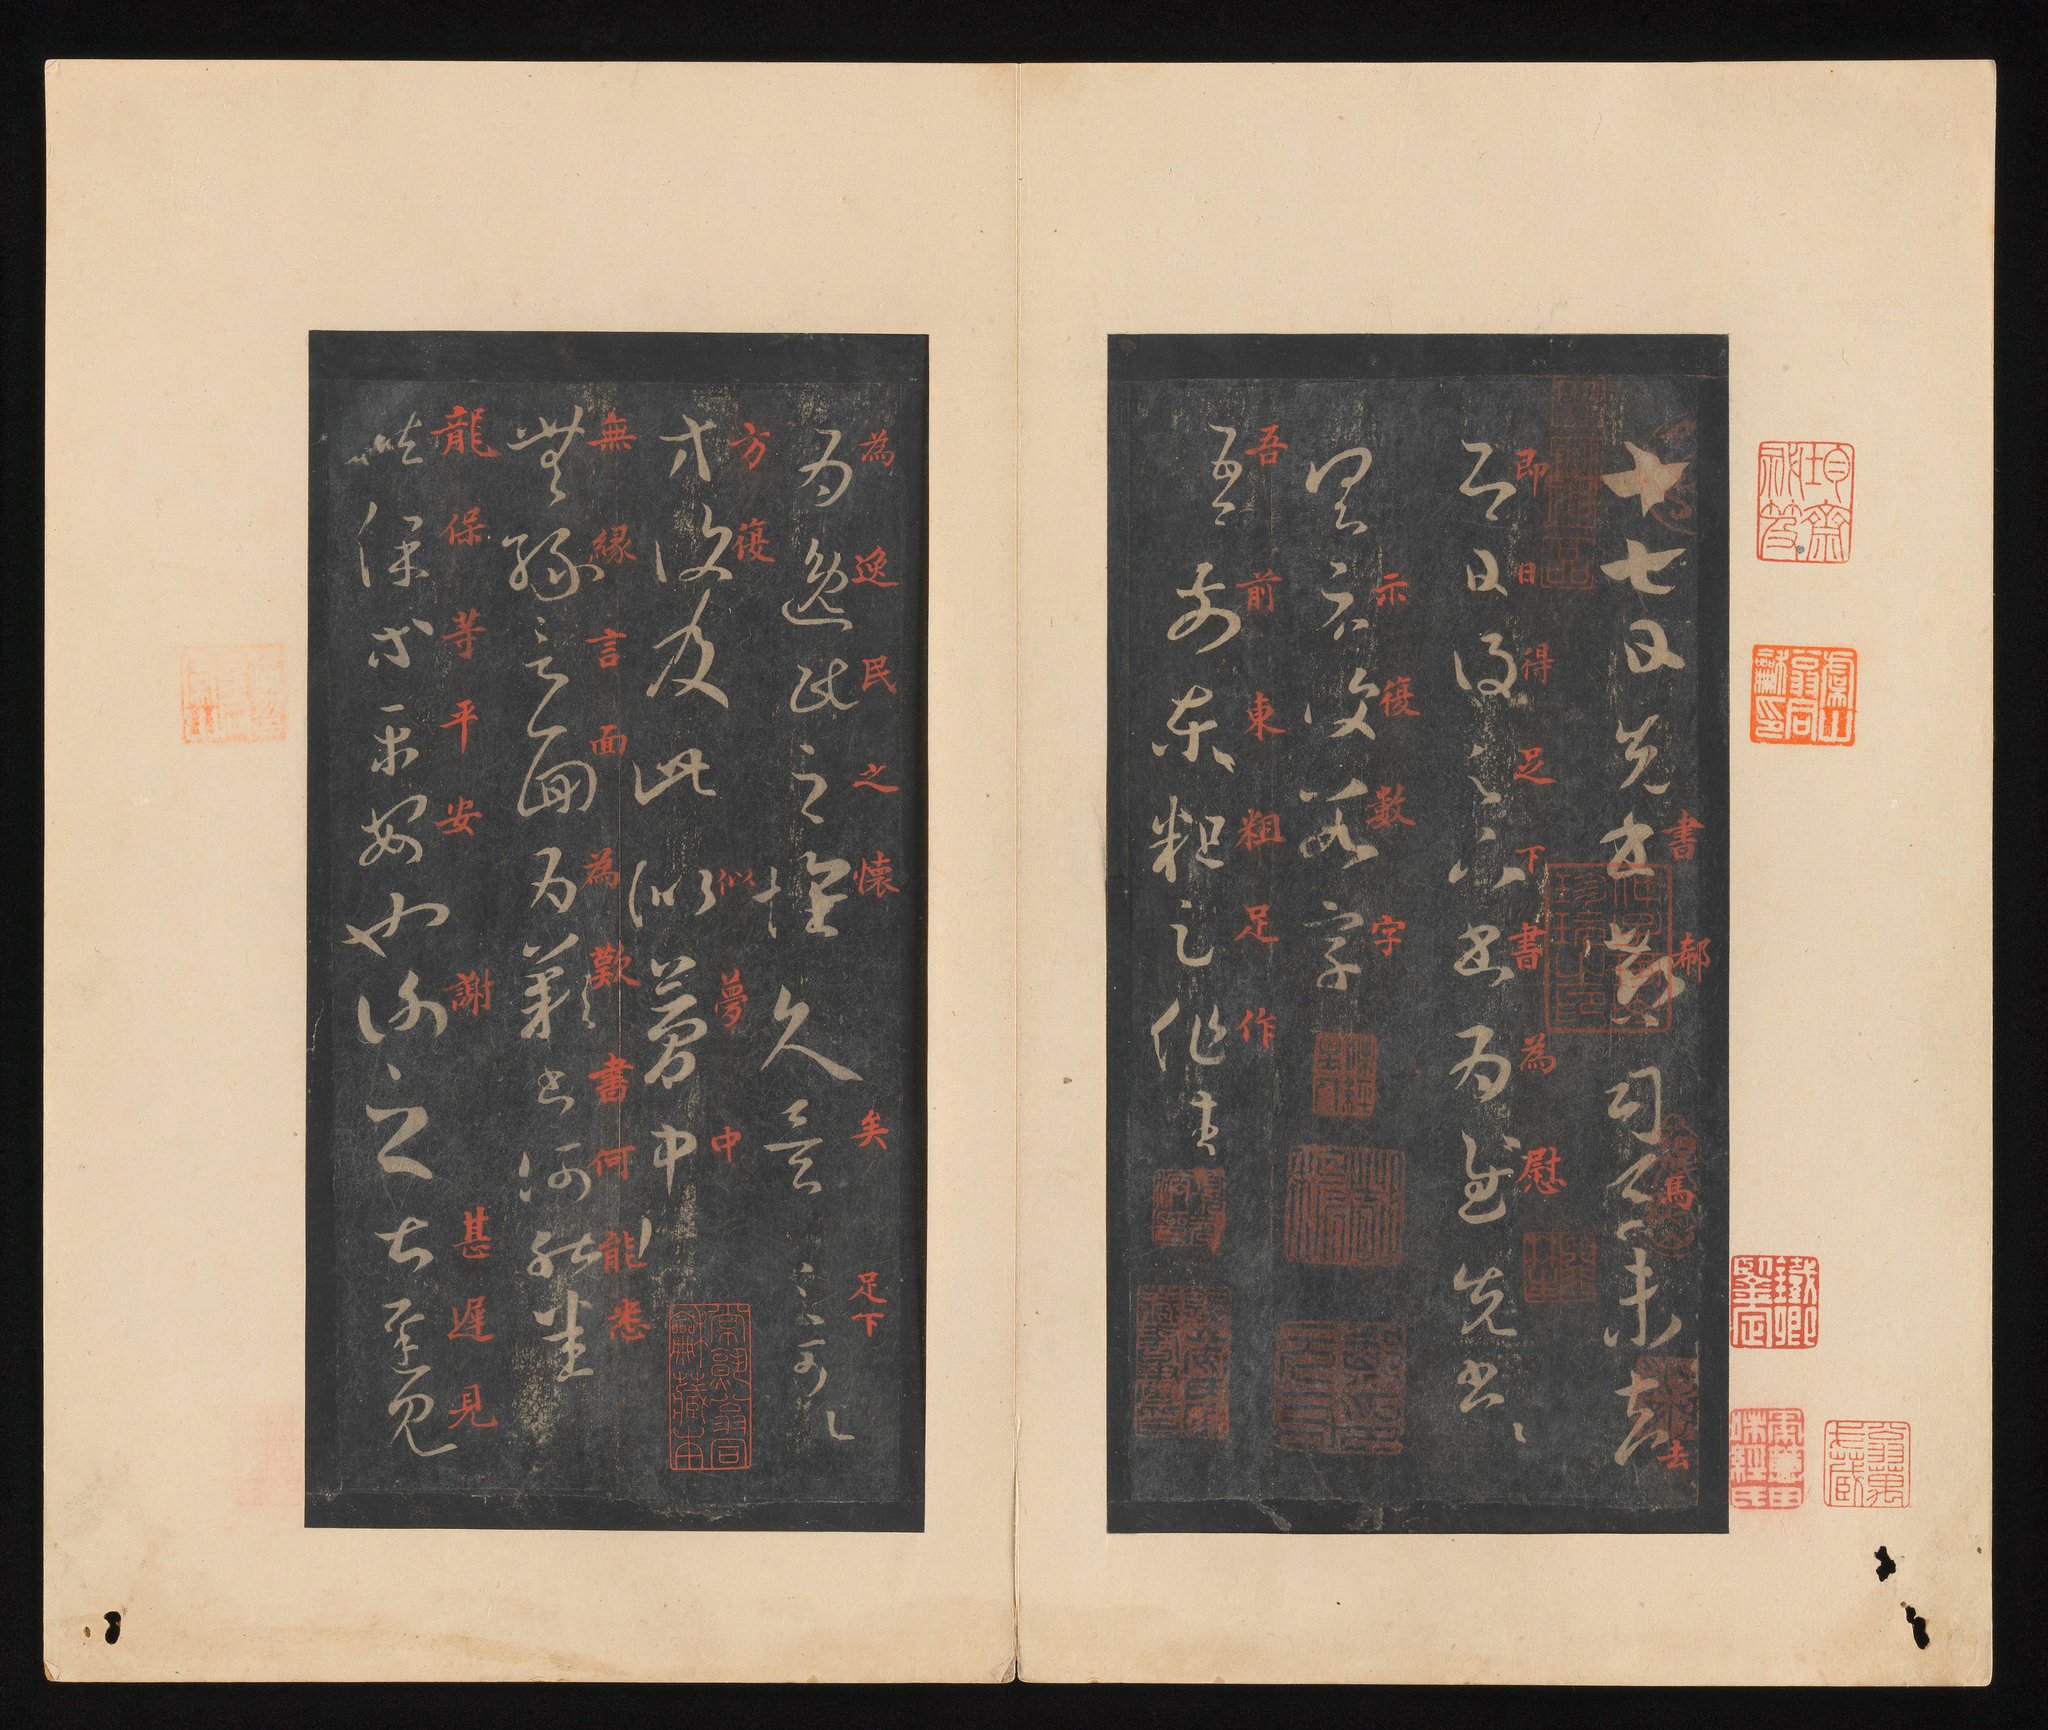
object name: rubbing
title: On the Seventeenth Day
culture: chinese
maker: wang xizhi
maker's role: calligrapher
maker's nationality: chinese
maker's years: 303-361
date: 1201-1300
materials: ink, paper